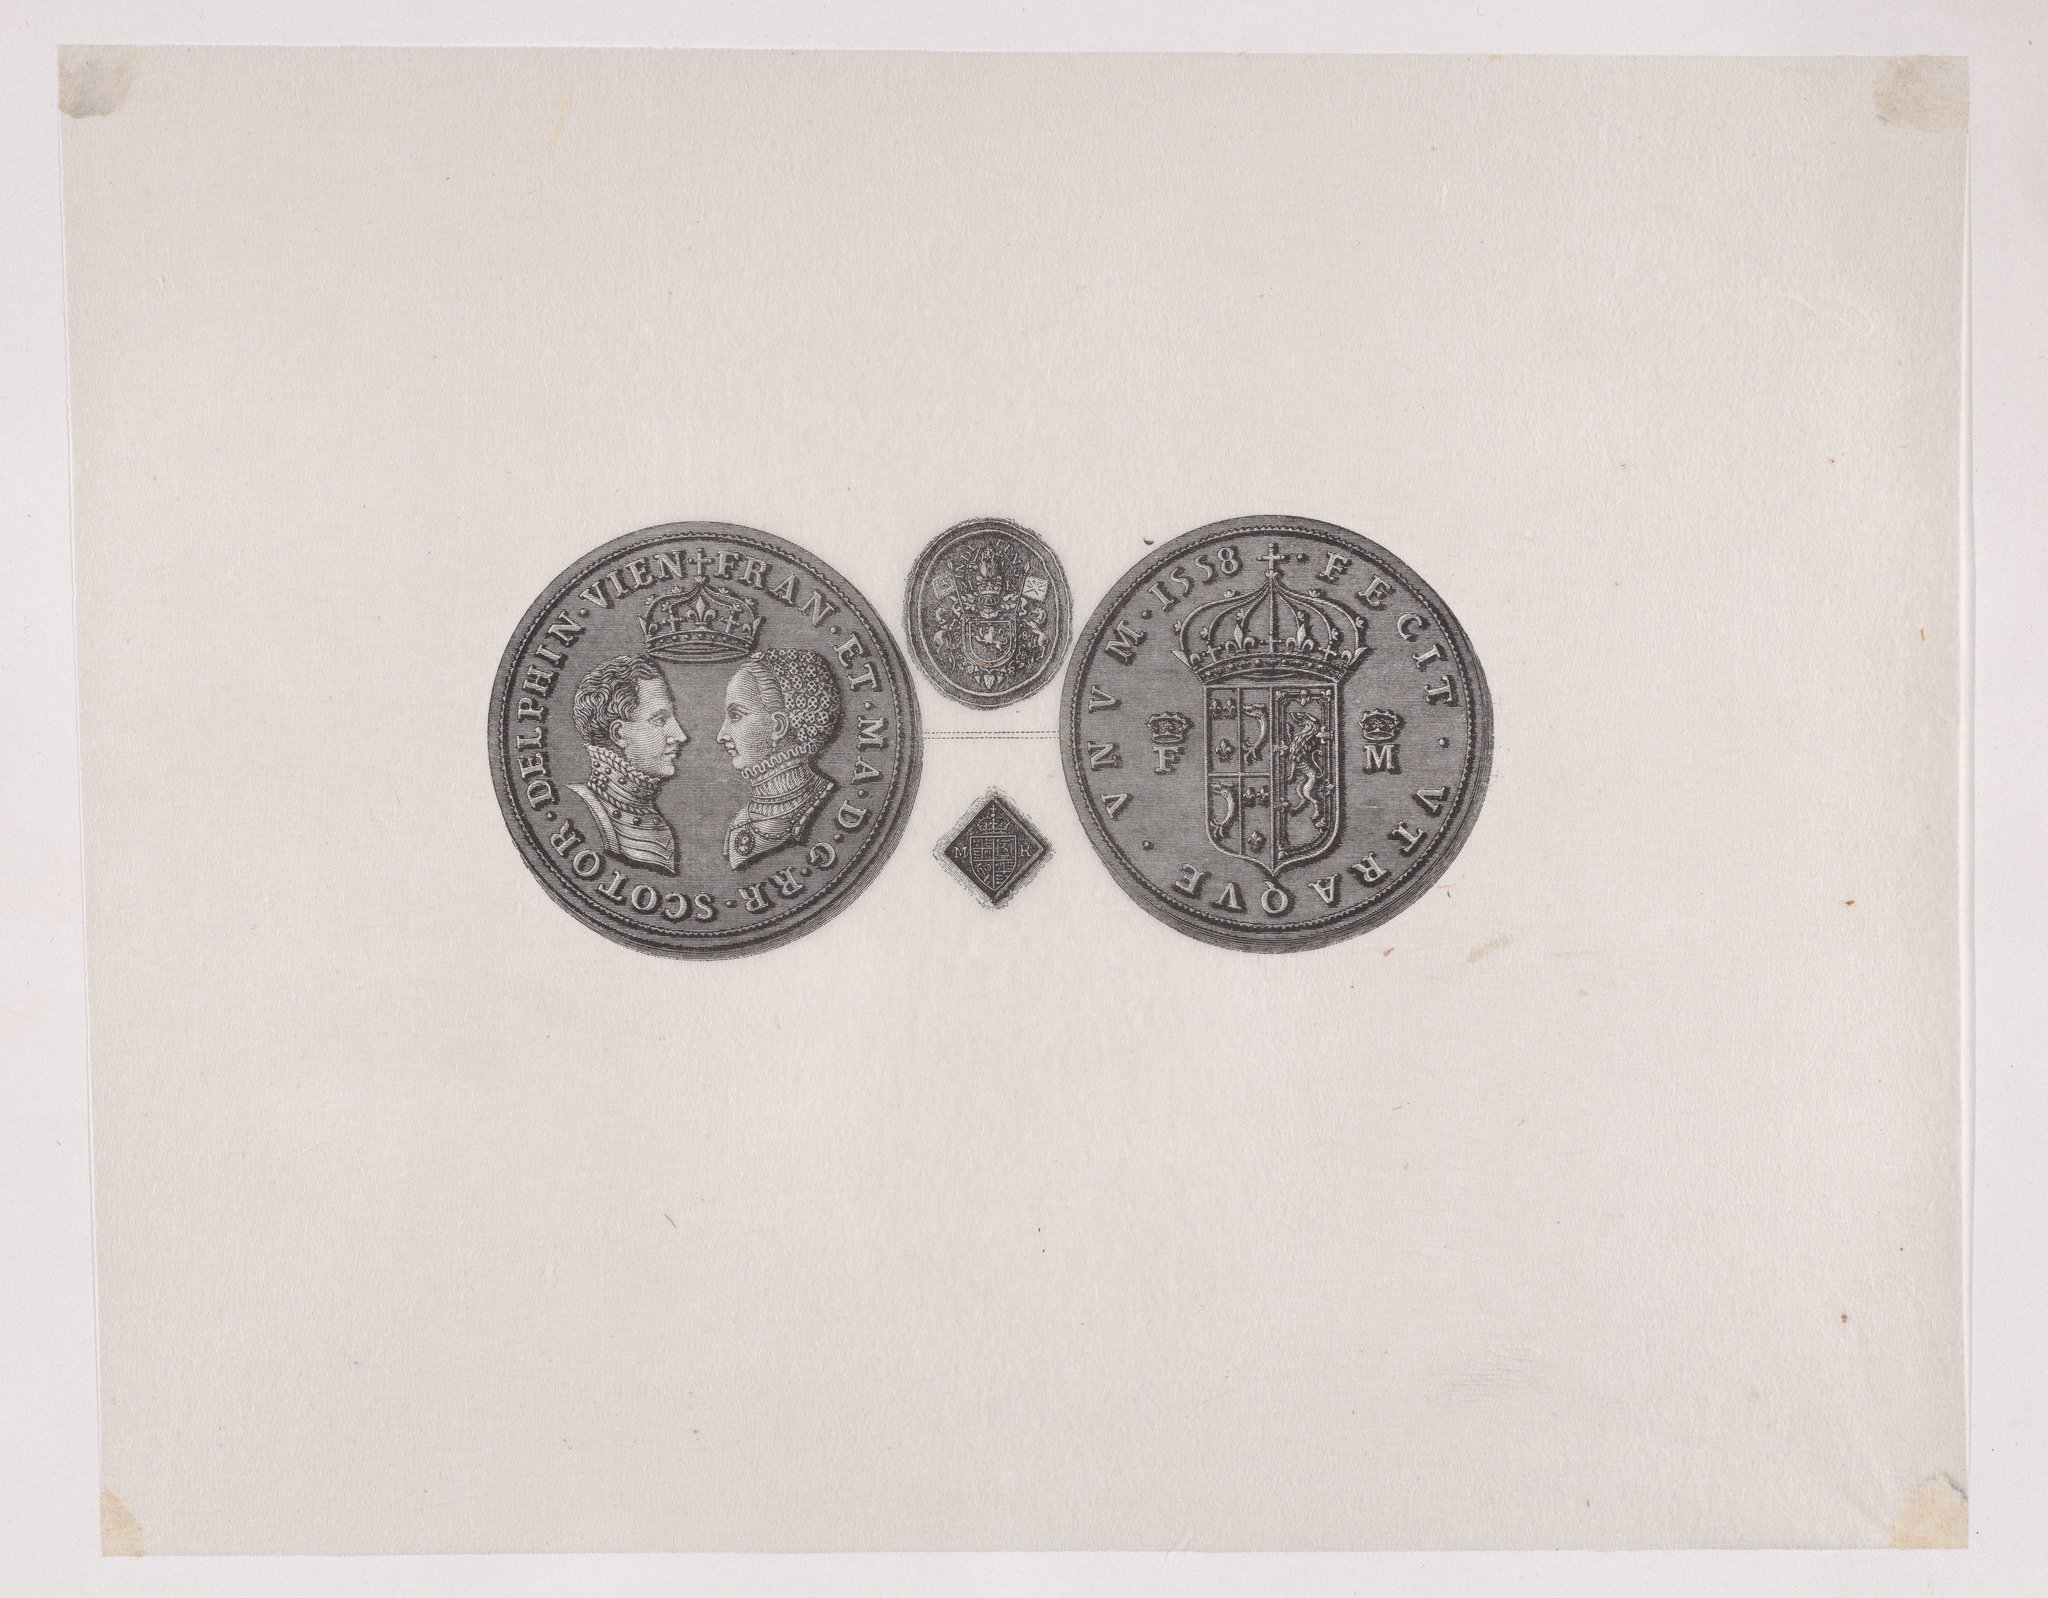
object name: print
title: Medal commemorating the marriage of Mary, Queen of Scots to the Dauphin Francis of France, with Mary's privy seal and signet ring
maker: john west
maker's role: artist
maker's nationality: british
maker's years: 1847-1855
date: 1849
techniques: engraving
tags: coat of arms,mary queen of scots